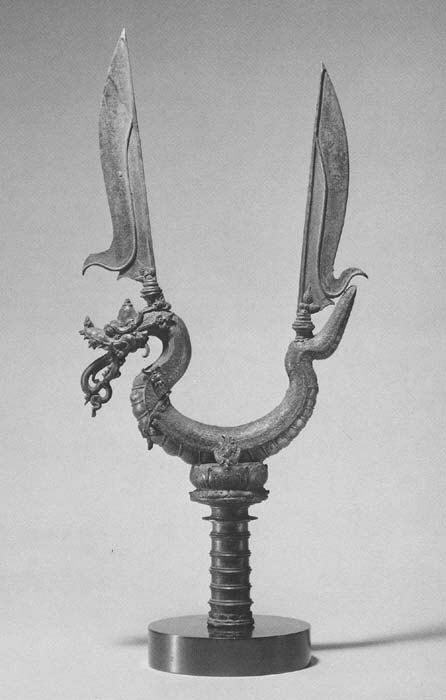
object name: halberd head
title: Halberd Head with Naga and Blades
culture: indonesian, javanese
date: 1251-1300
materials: copper alloy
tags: weapons,snakes